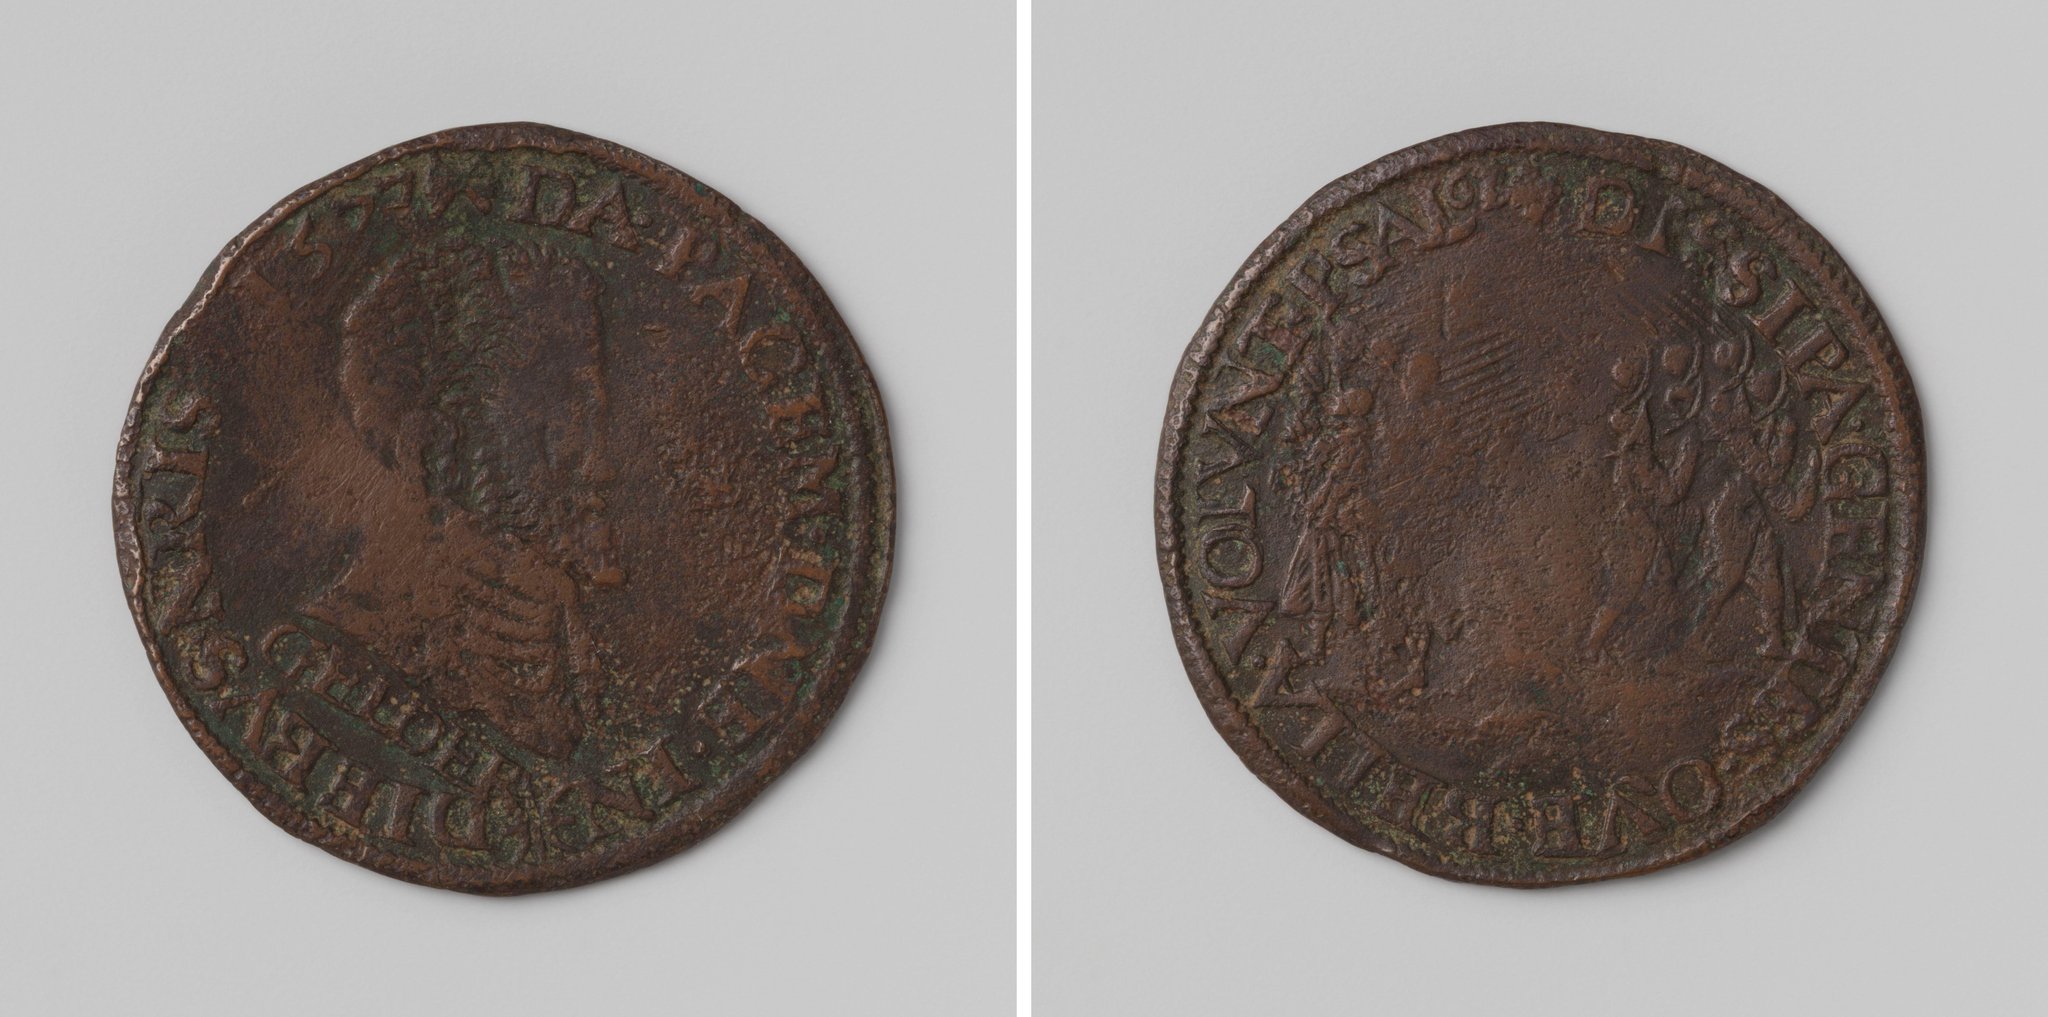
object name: jeton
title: Afbreken van de onderhandelingen met don Juan, ter ere van Filips II, koning van Spanje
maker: Anonymous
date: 1577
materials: copper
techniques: striking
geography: arnhem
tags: philip ii of spain, don juan van oostenrijk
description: Koperen penning. Voorzijde: borststuk man boven opschrift tussen kruis en vuurslag, waar vonk uitschiet binnen omschrift. Keerzijde: Spaanse en Nederlandse soldaten die elkaar rug toekeren binnen omschrift